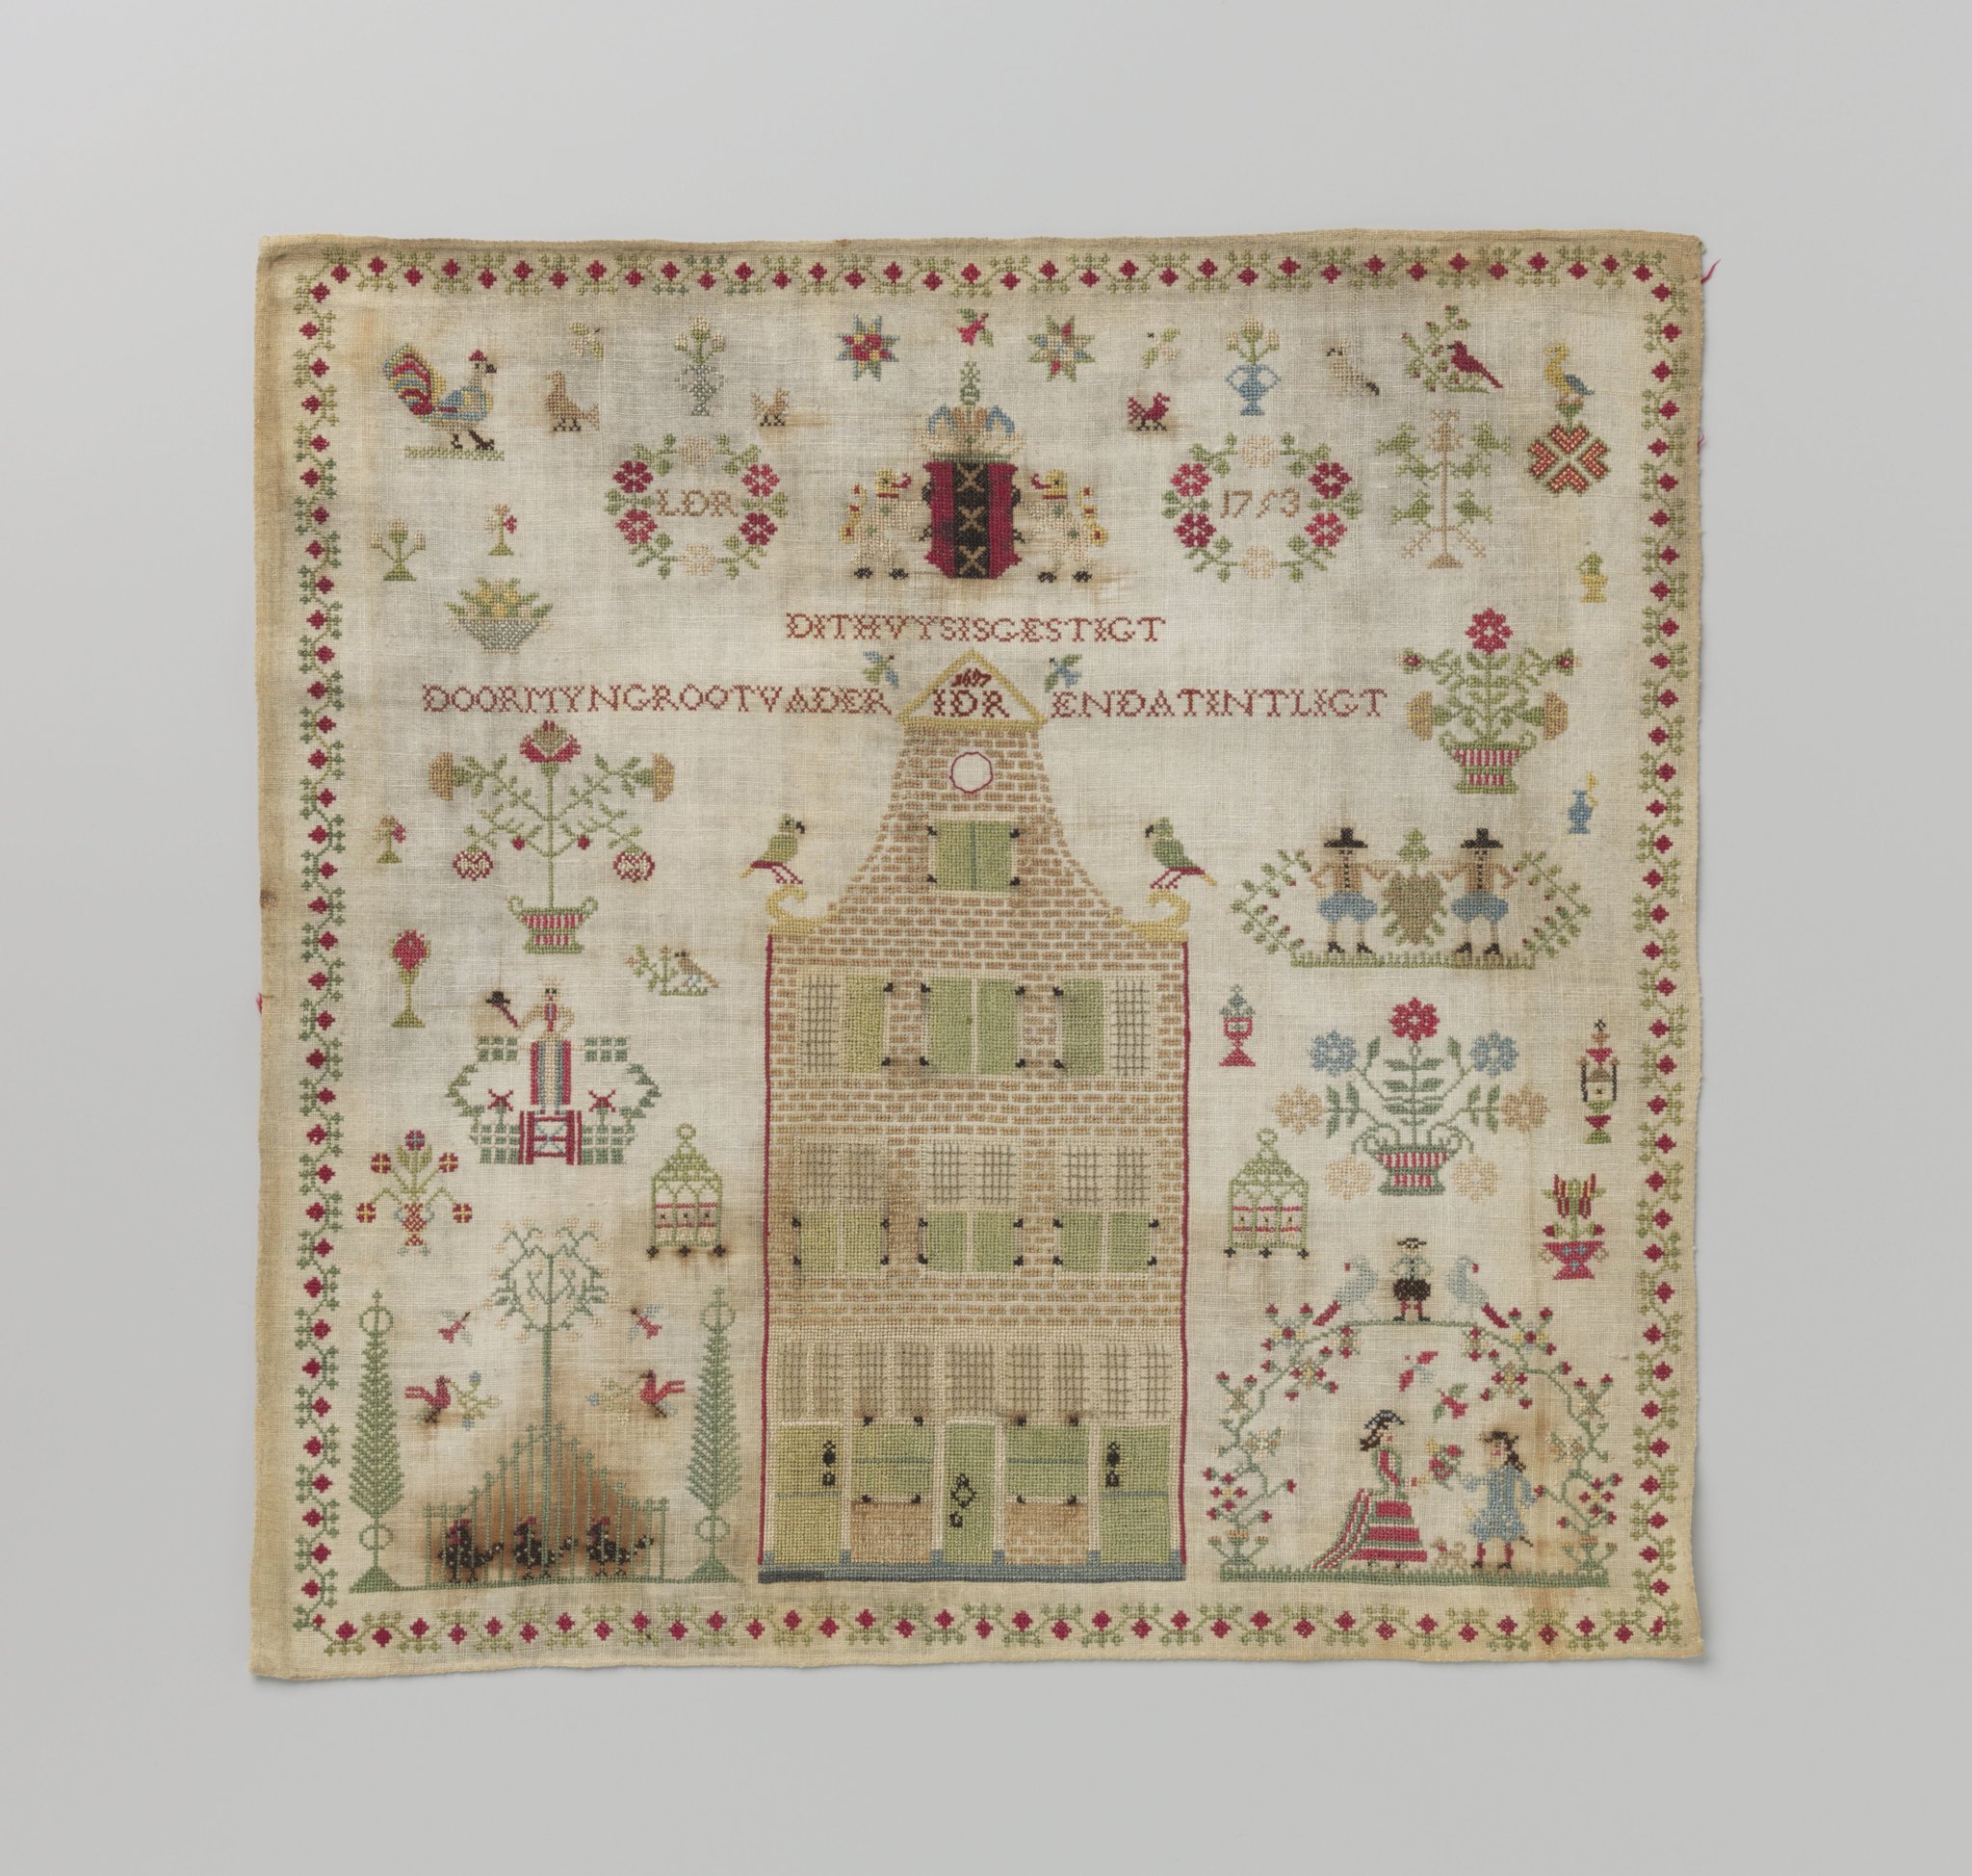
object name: merkdoek, merklap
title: Merklap van katoenen mousseline waarop een huis met klokgevel onder het Amsterdamse stadswapen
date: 1753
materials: cotton, textile, silk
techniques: embroidered, weave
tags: lammertje de ronbaij, laurentia de ronbaij, amsterdam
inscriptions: date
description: Het tegenwoordige huis Egelantiersgracht 14 werd op 17 juli 1693 door Jacob de Ronbaij gekocht. De letters IDR op de gevel verwijzen naar deze blauwverver (1655-1749). Kennelijk heeft hij het huis in 1697 laten verbouwen. Zijn zoon Willem (1699-1758), kousenverver en zijn echtgenote Jacomina Selijns (1702-1783) hadden drie dochters: Lammertje (1738-41), Laurentia (1740-1819) en Lammertje (1743-1819). Gezien hun leeftijd, was het hoogstwaarschijnlijk Laurentia die de merklap heeft gemaakt. In haar inventaris van 1820 wordt 'Een geschildert kist met eenig hantwerk f. 1,25' (op zolder) vermeld. Hoewel zij nog steeds in het ouderlijk huis woonde, was het door haar erven gekocht en verandert. Oorspronkelijk waren het twee huizen, no.'s 8 en 10 (Laurentia woonde in 8), maar nu tot één geheel gemaakt. [B. du Mortier 2002] Jacob de Roubaij, blauwverver, liet het door hem gekochte huis aan de Egelantiersgracht (nu nr. 14) in 1697 verbouwen. Zijn zoon Willem was kousenverver en getrouwd met Jacomina Selijns. Van hun drie dochters is Laurentia de vermoedelijke maakster, maar het enorm grote huis op haar merklap moet wel door een ander - met een bouwkundig oog - zijn voorgetekend. Opmerkelijk zijn de hoenderhof met de cypressen en de elegante scène, respectievelijk links en rechts onder, waarin een dame een boeket wordt gepresenteerd door een elegant geklede heer met lange pruik en een degen op zijn zij. [Schipper-van Lottum, M.G.A. 1995]